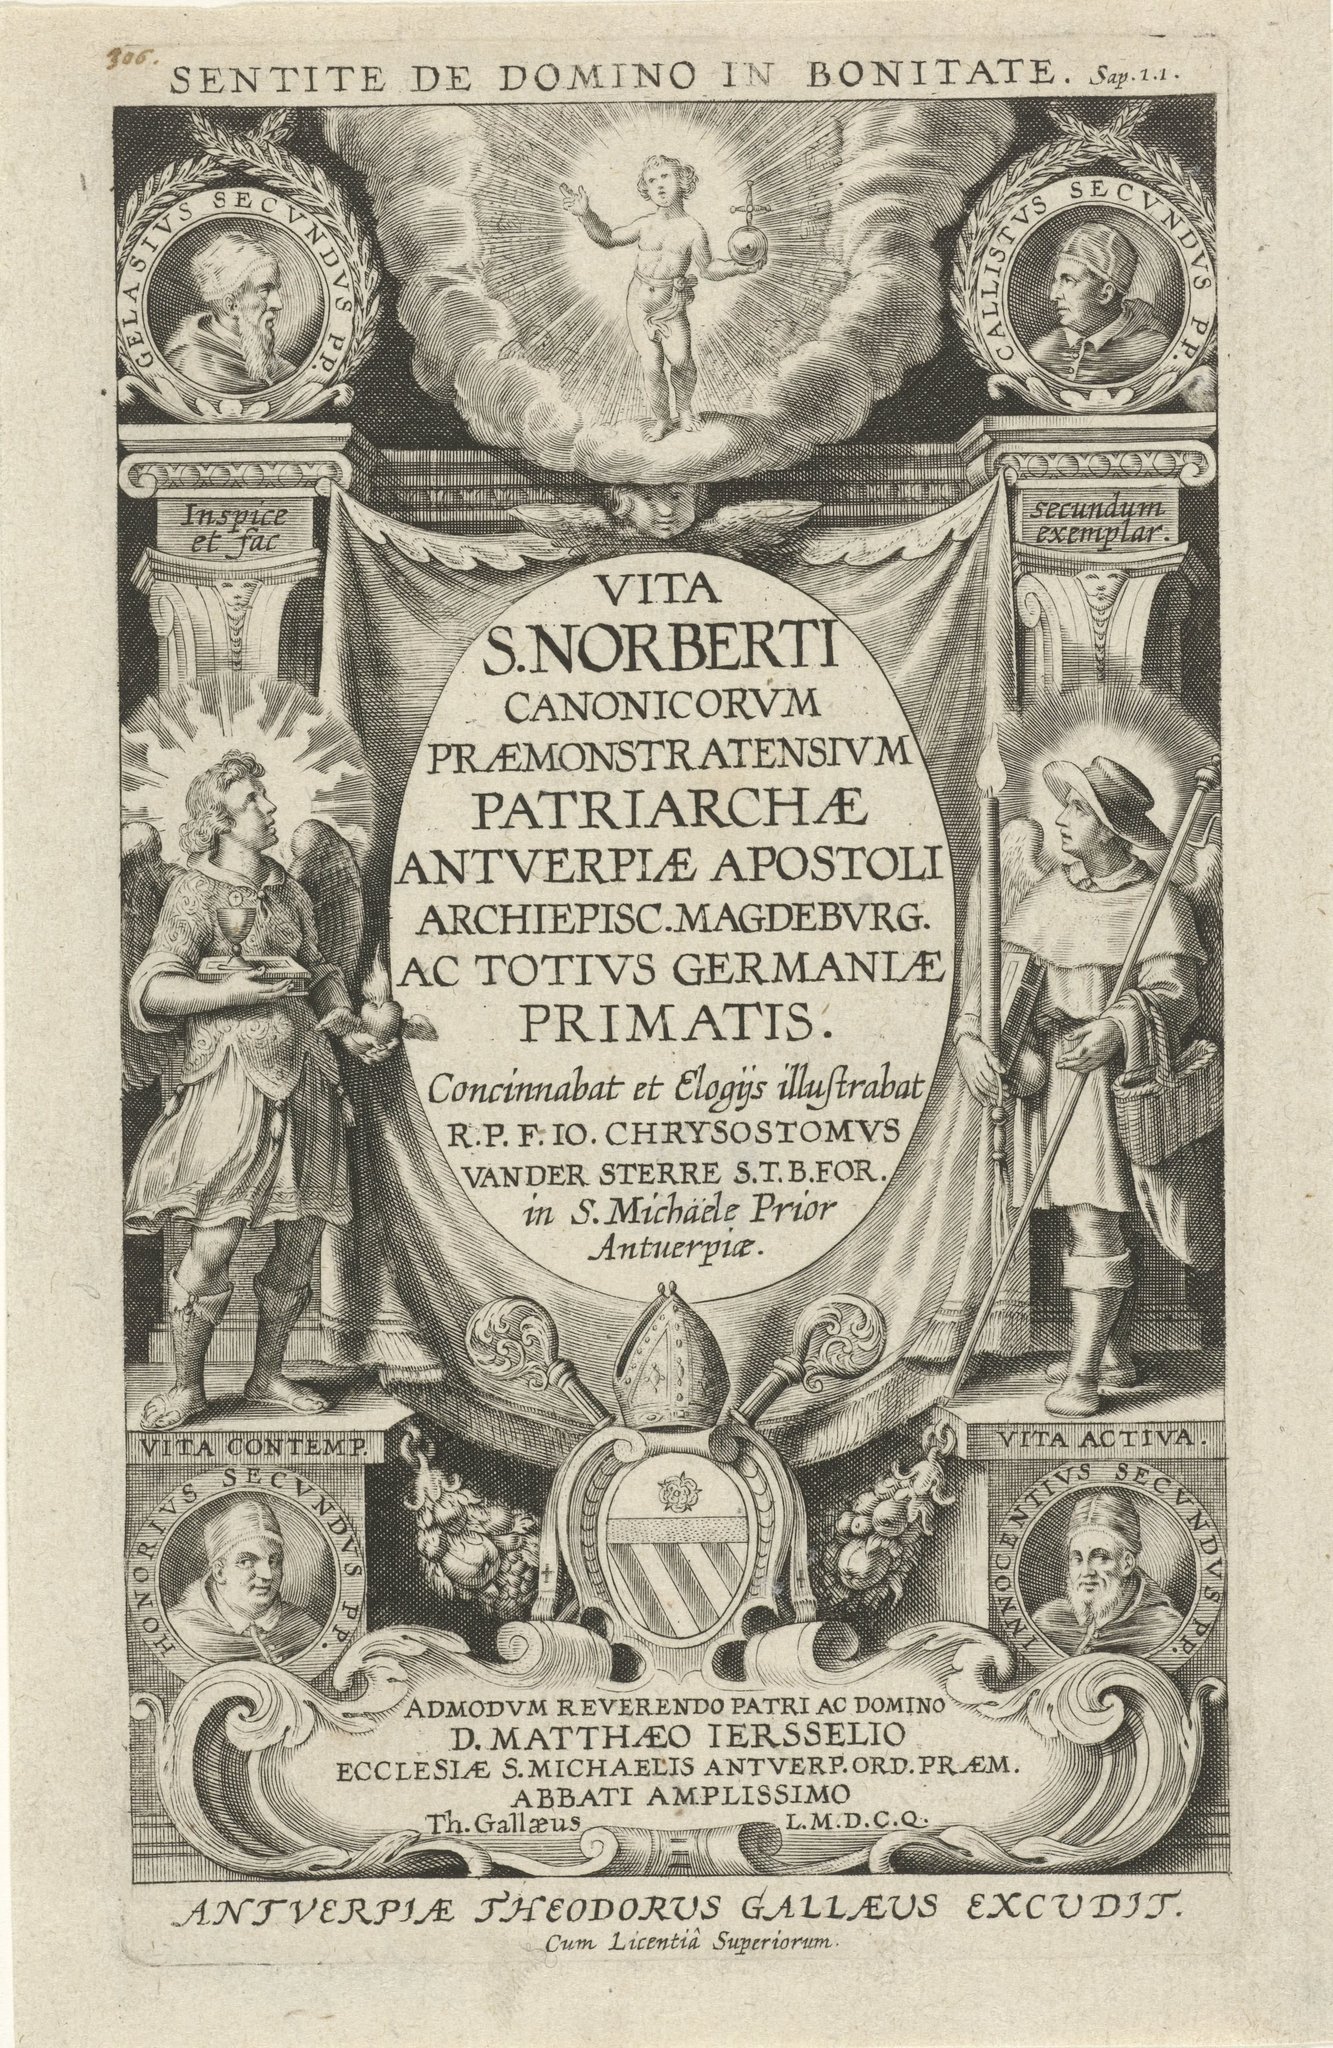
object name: titelblad, titelpagina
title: Titelpagina voor: Johannes Chrysostomos van der Sterre, Vita S. Norberti canonicorum praemonstratensium patriarchae Antverpiae apostoli (…), 1622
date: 1622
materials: paper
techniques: engraving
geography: antwerp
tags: active life; 'vita attiva' (ripa), contemplative life; 'vita contemplativa' (ripa), christ as youth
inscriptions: number: ‘306’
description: In een ovale lijst de titel van het boek. Aan weerszijden van de lijst de personificatie van de Vita Contemplativa (links) en de Vita Activa (rechts). Beide kijken naar het Christuskind dat boven de titel wordt voorgesteld. In elke hoek van de prent de portretten van de pausen die belangrijk waren in het leven van de heilige Norbertus: Innocentius II, Honorius II, Calixtus II en Gelasius II.